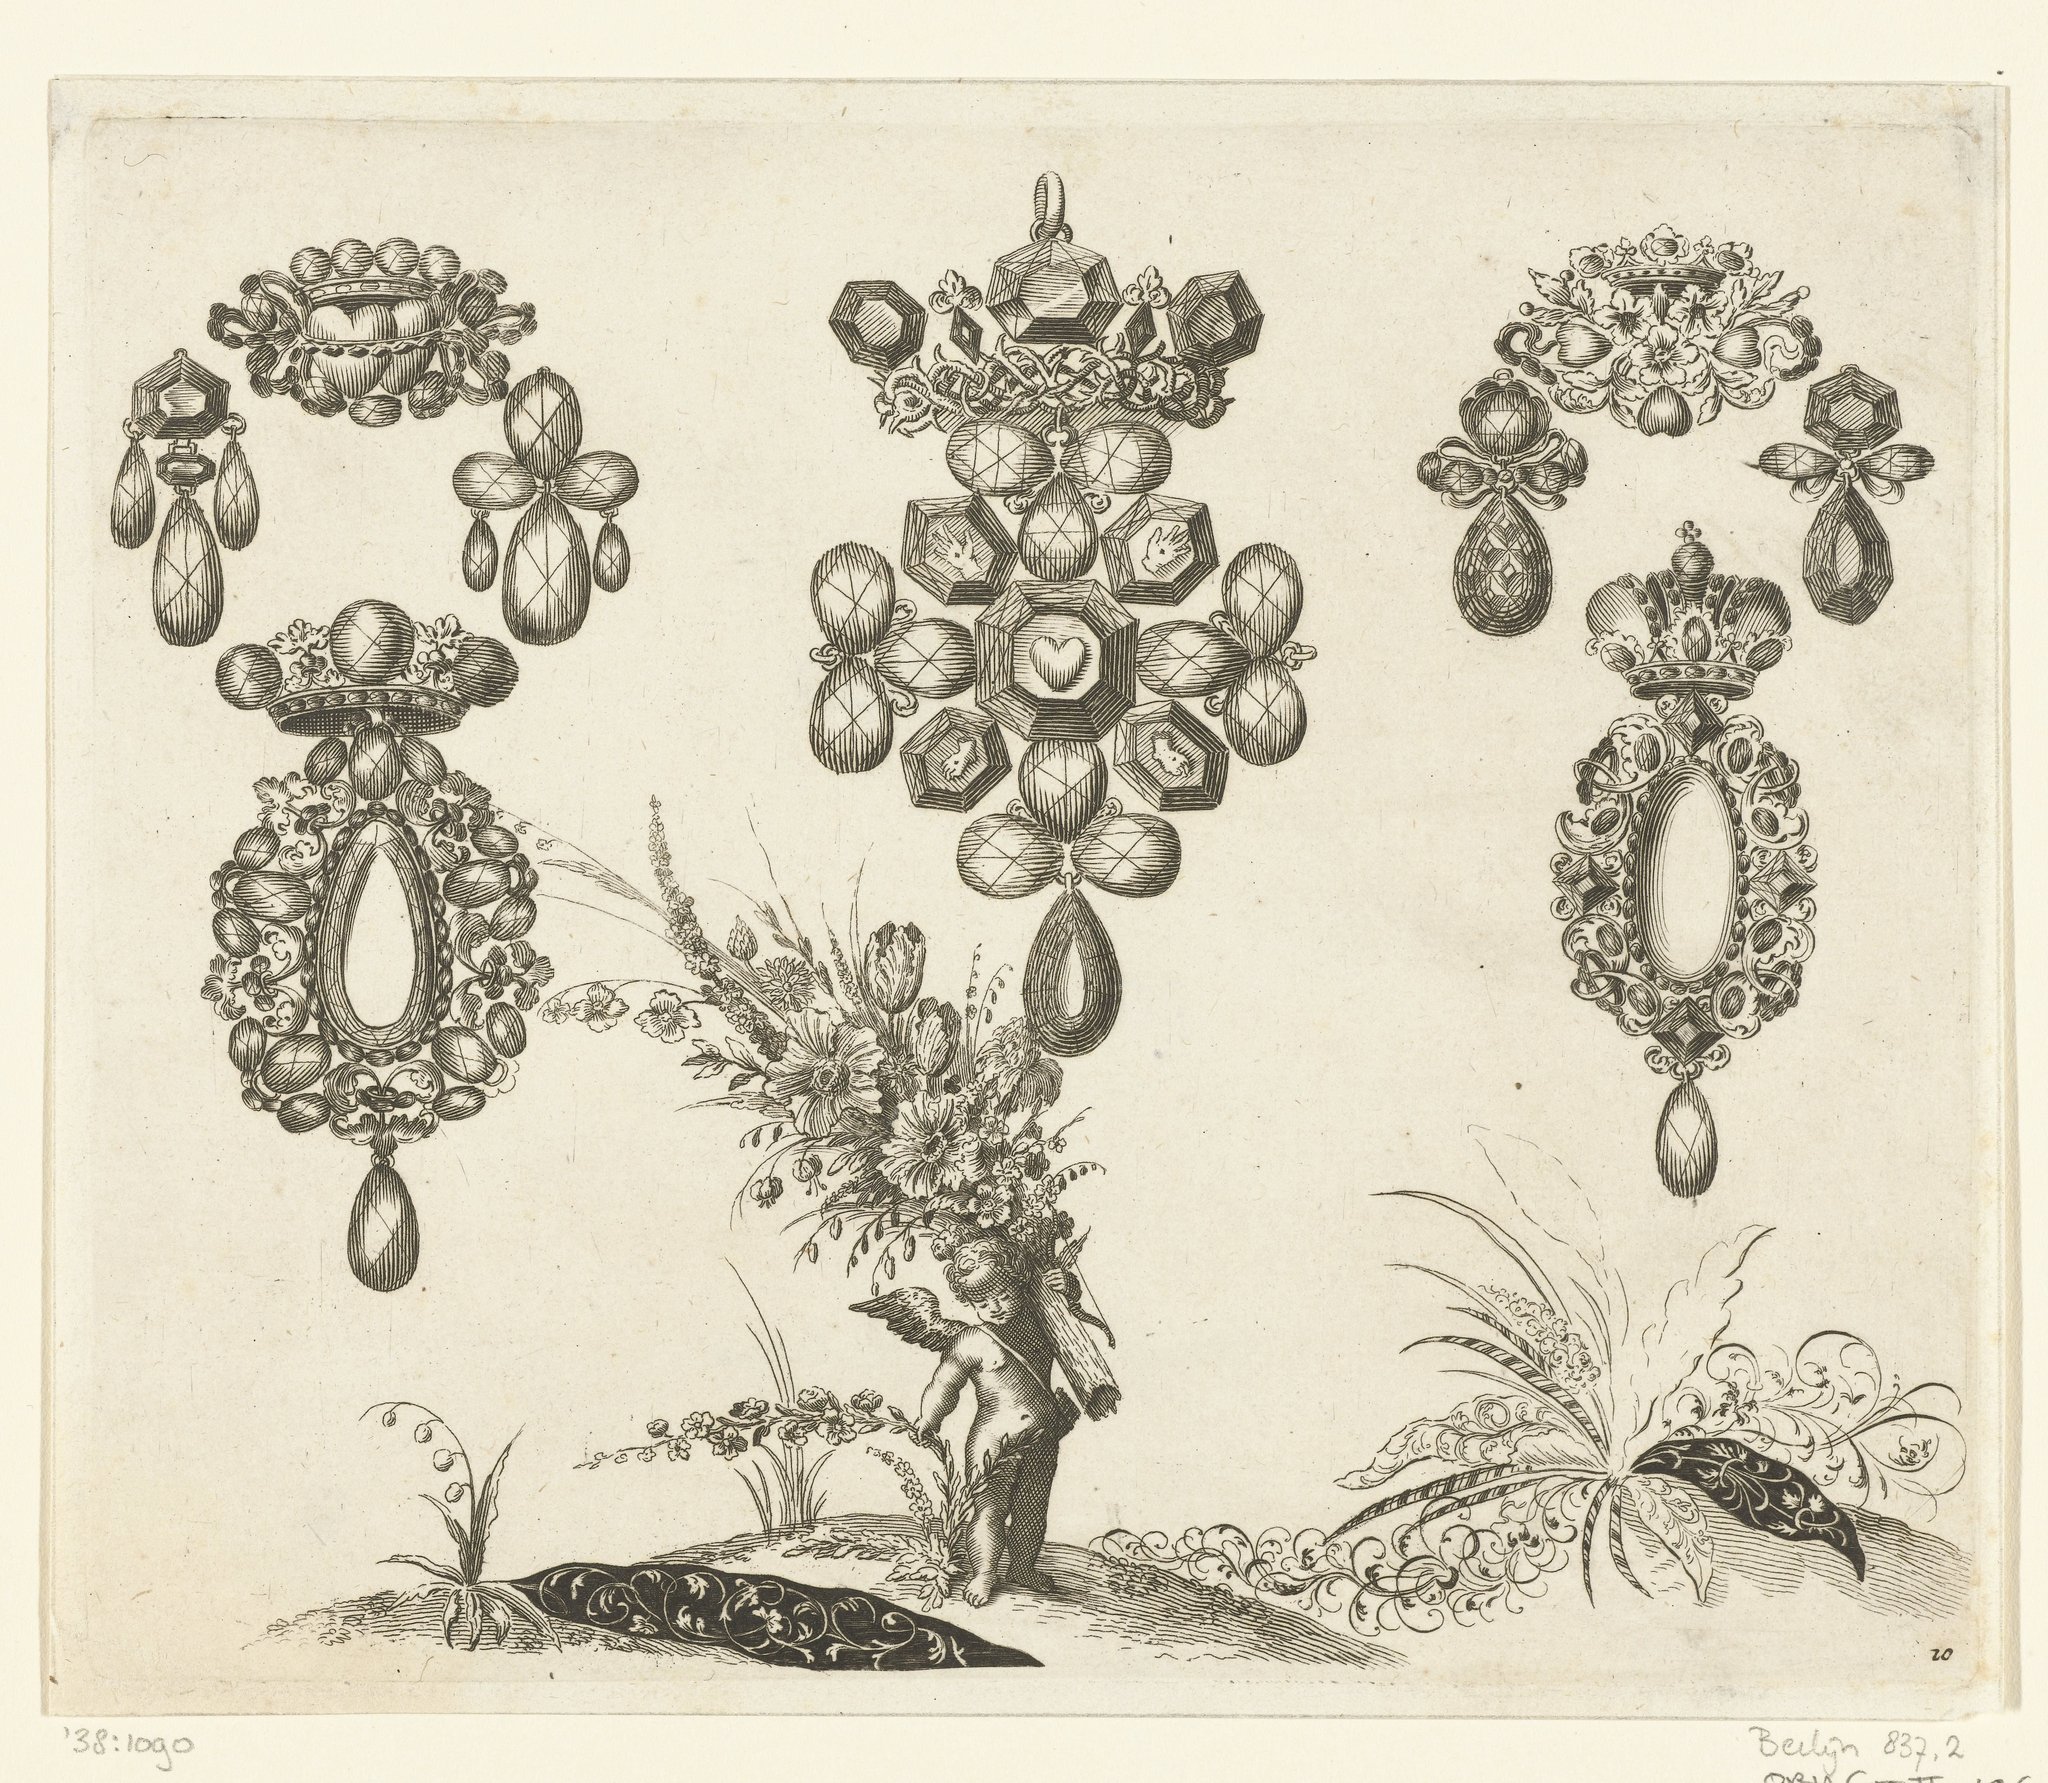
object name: ornament print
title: Liure de Feuillages et d'Ouvrages d'Orfevrerie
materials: paper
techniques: engraving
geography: amsterdam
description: Onderaan loopt een putto met een boeket bloemen. Kopie naar blad 3 van Friedrich Jacob Morisson uitgegeven in Wenen in 1697. Blad 10 uit serie met bladranken en ontwerpen voor edelsmeden, Nederlandse kopieën van ontwerpen door Thomas Lejuge, Jean Louis Durant en Friedrich Jacob Morisson. Tweede editie, tweede afdruk.